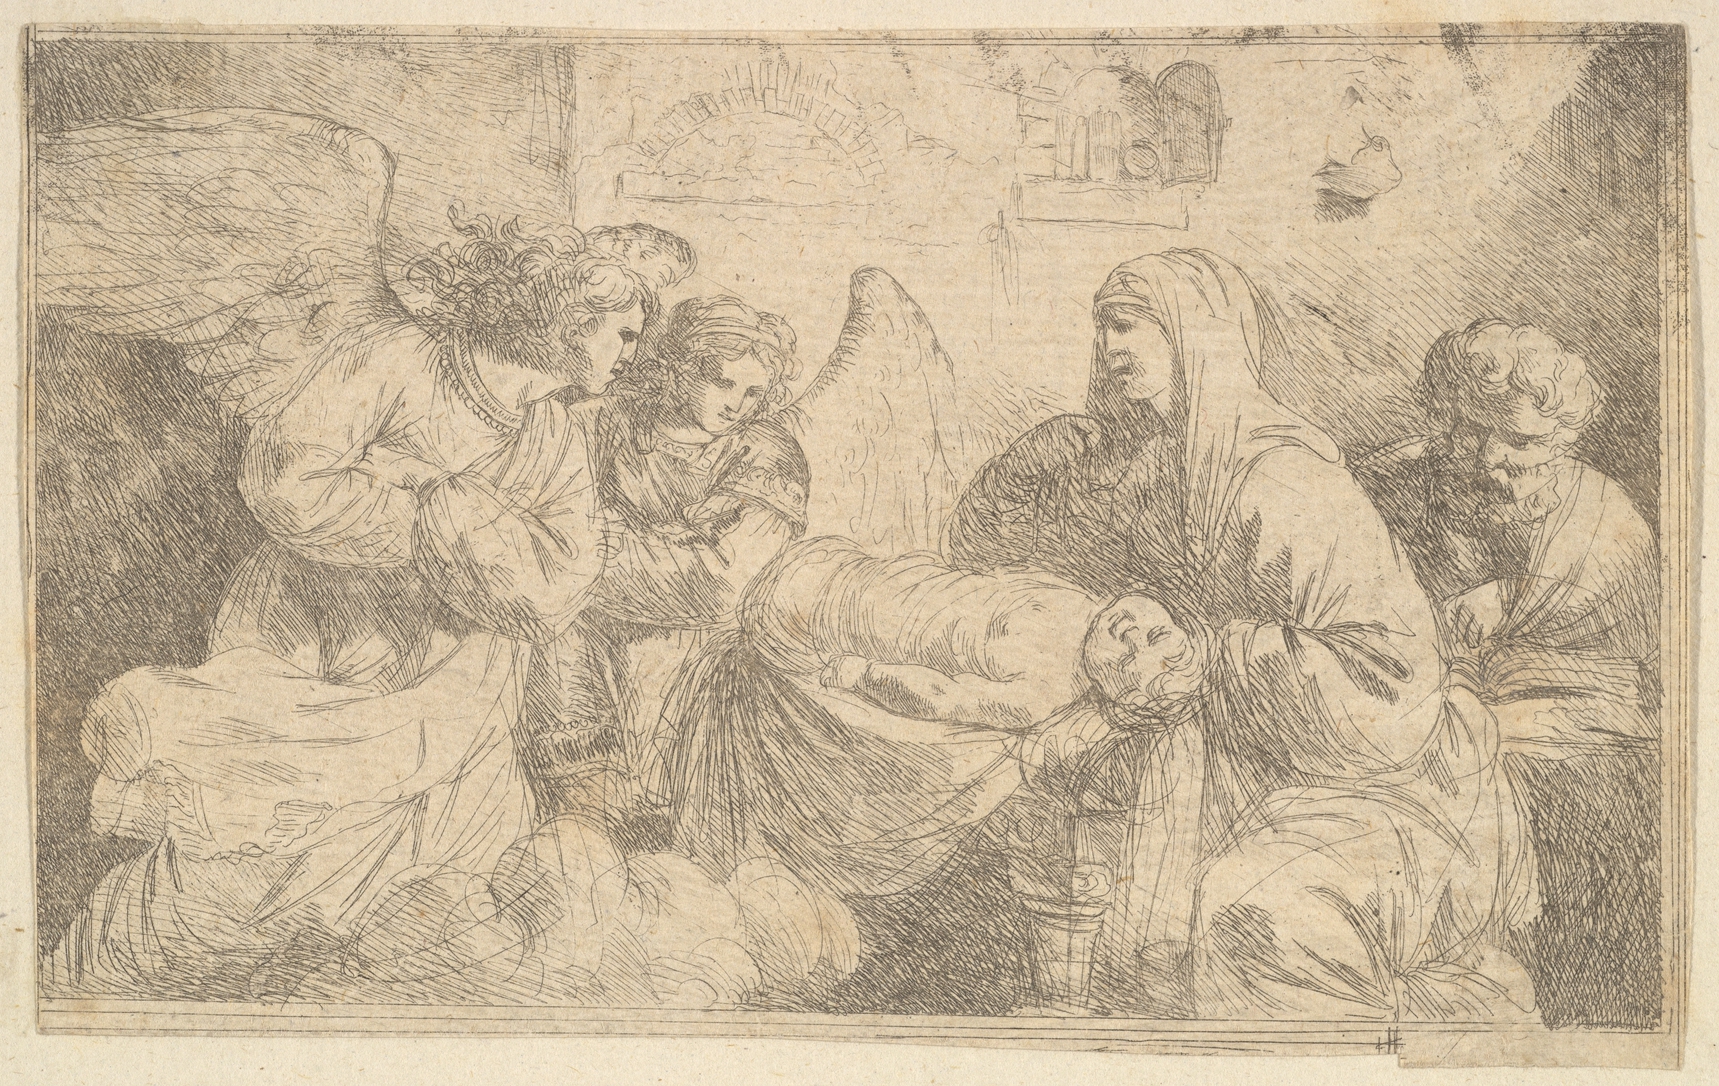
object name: print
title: La Nativité de Jésus-Christ (The Nativity of Christ)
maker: jean jacques lagrenée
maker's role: artist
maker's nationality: french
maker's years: 1739-1821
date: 1767-1800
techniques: etching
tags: angels,christ,virgin mary,nativity